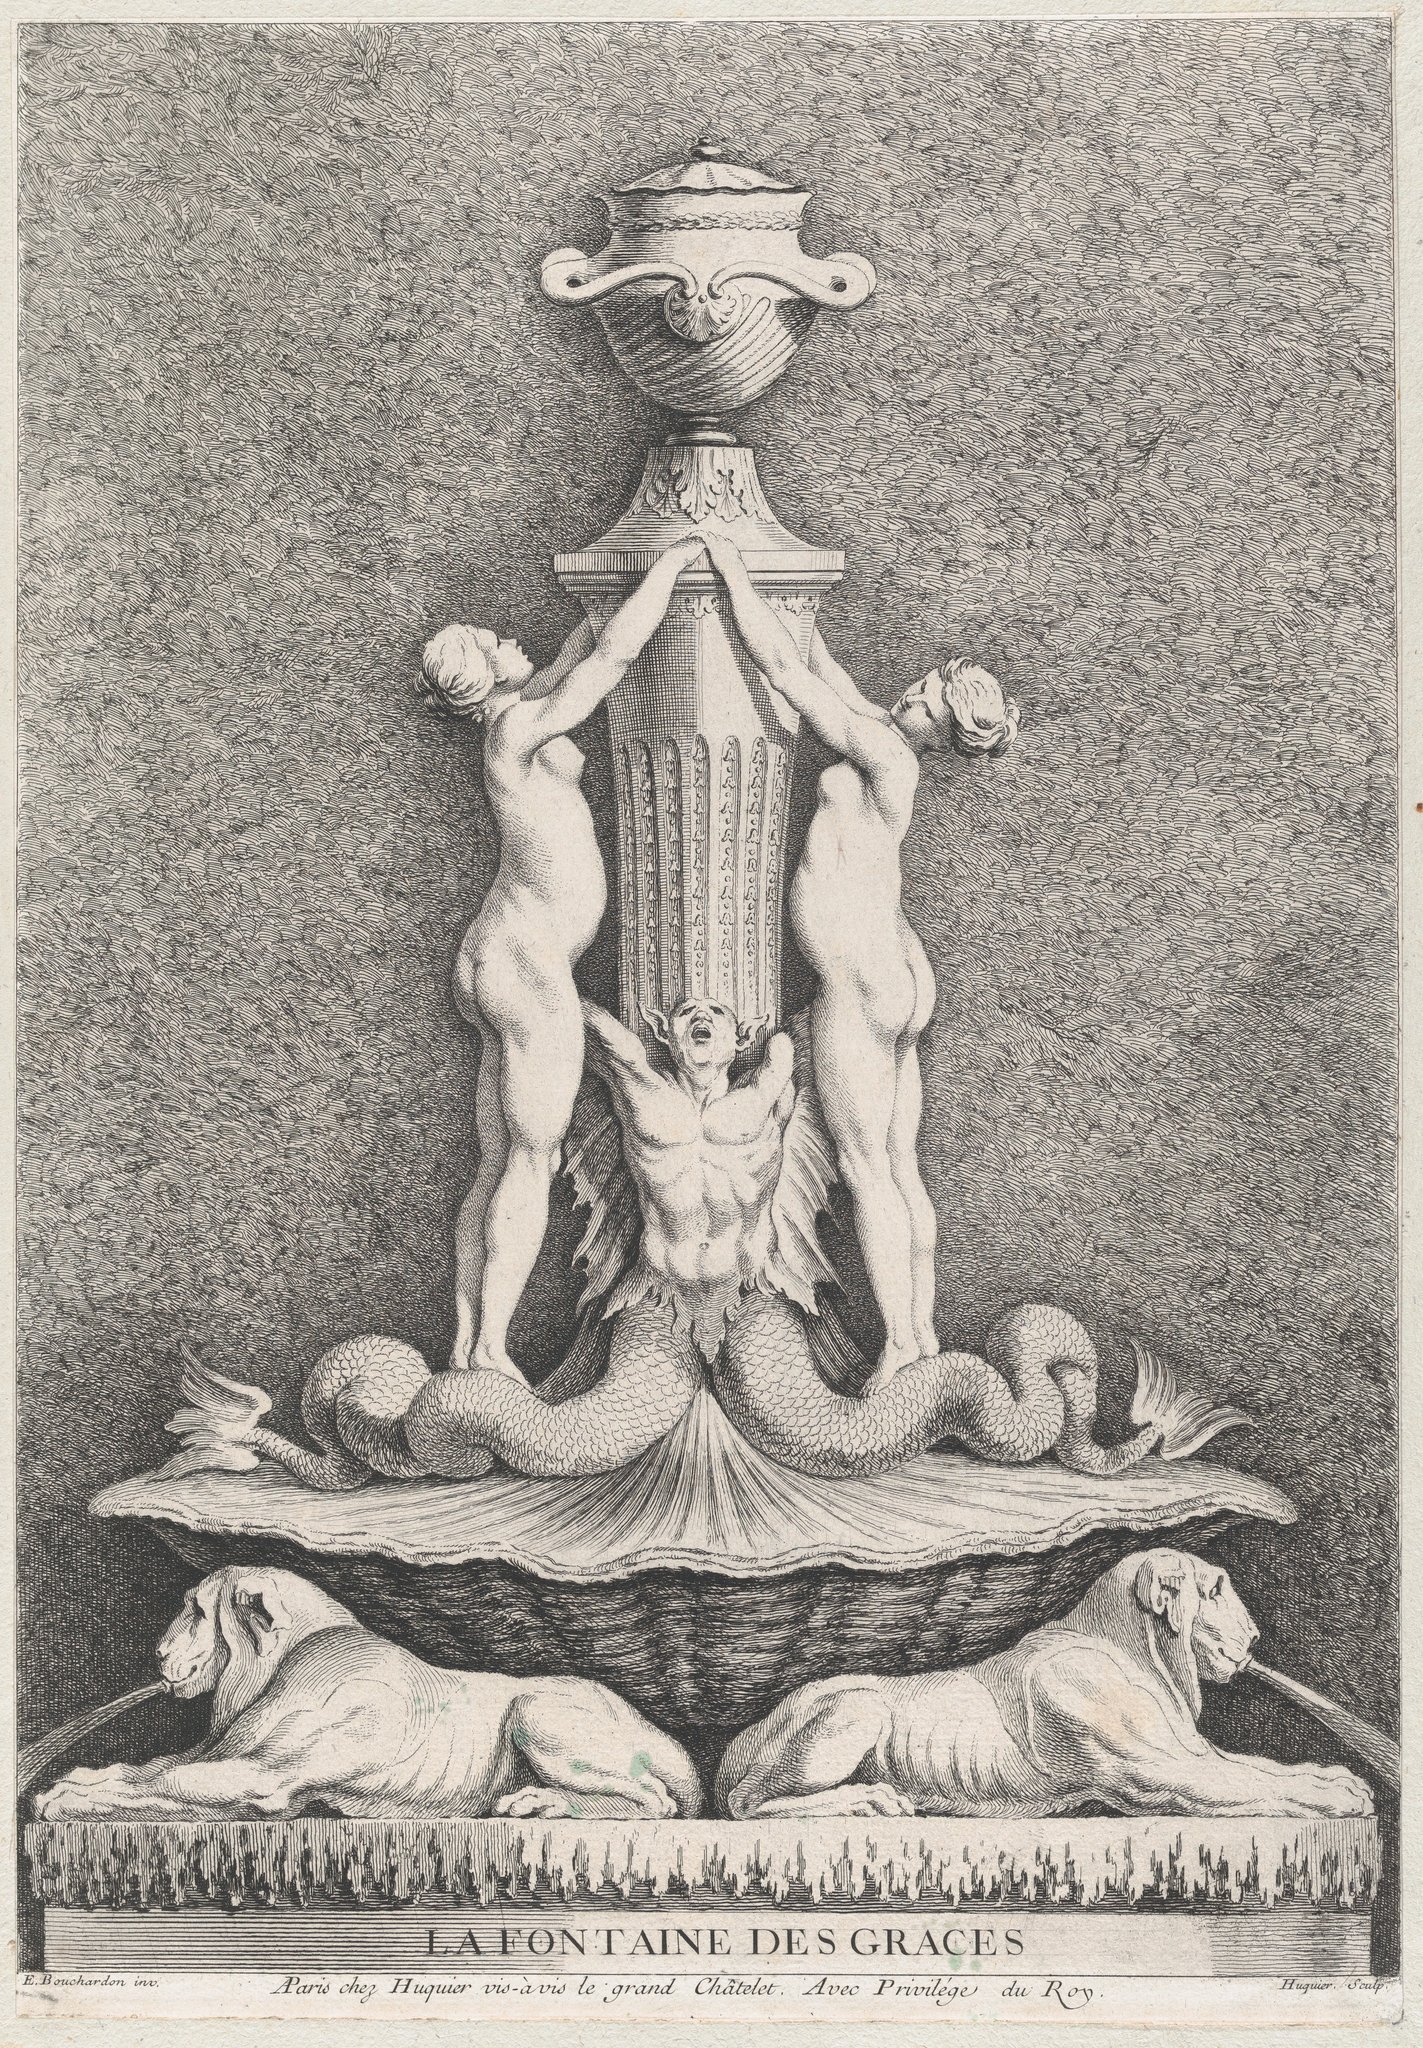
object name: print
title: The Fountain of the Graces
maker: gabriel huquier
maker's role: artist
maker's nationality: french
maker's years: 1695-1772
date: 1737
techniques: etching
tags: animals,fountains,female nudes